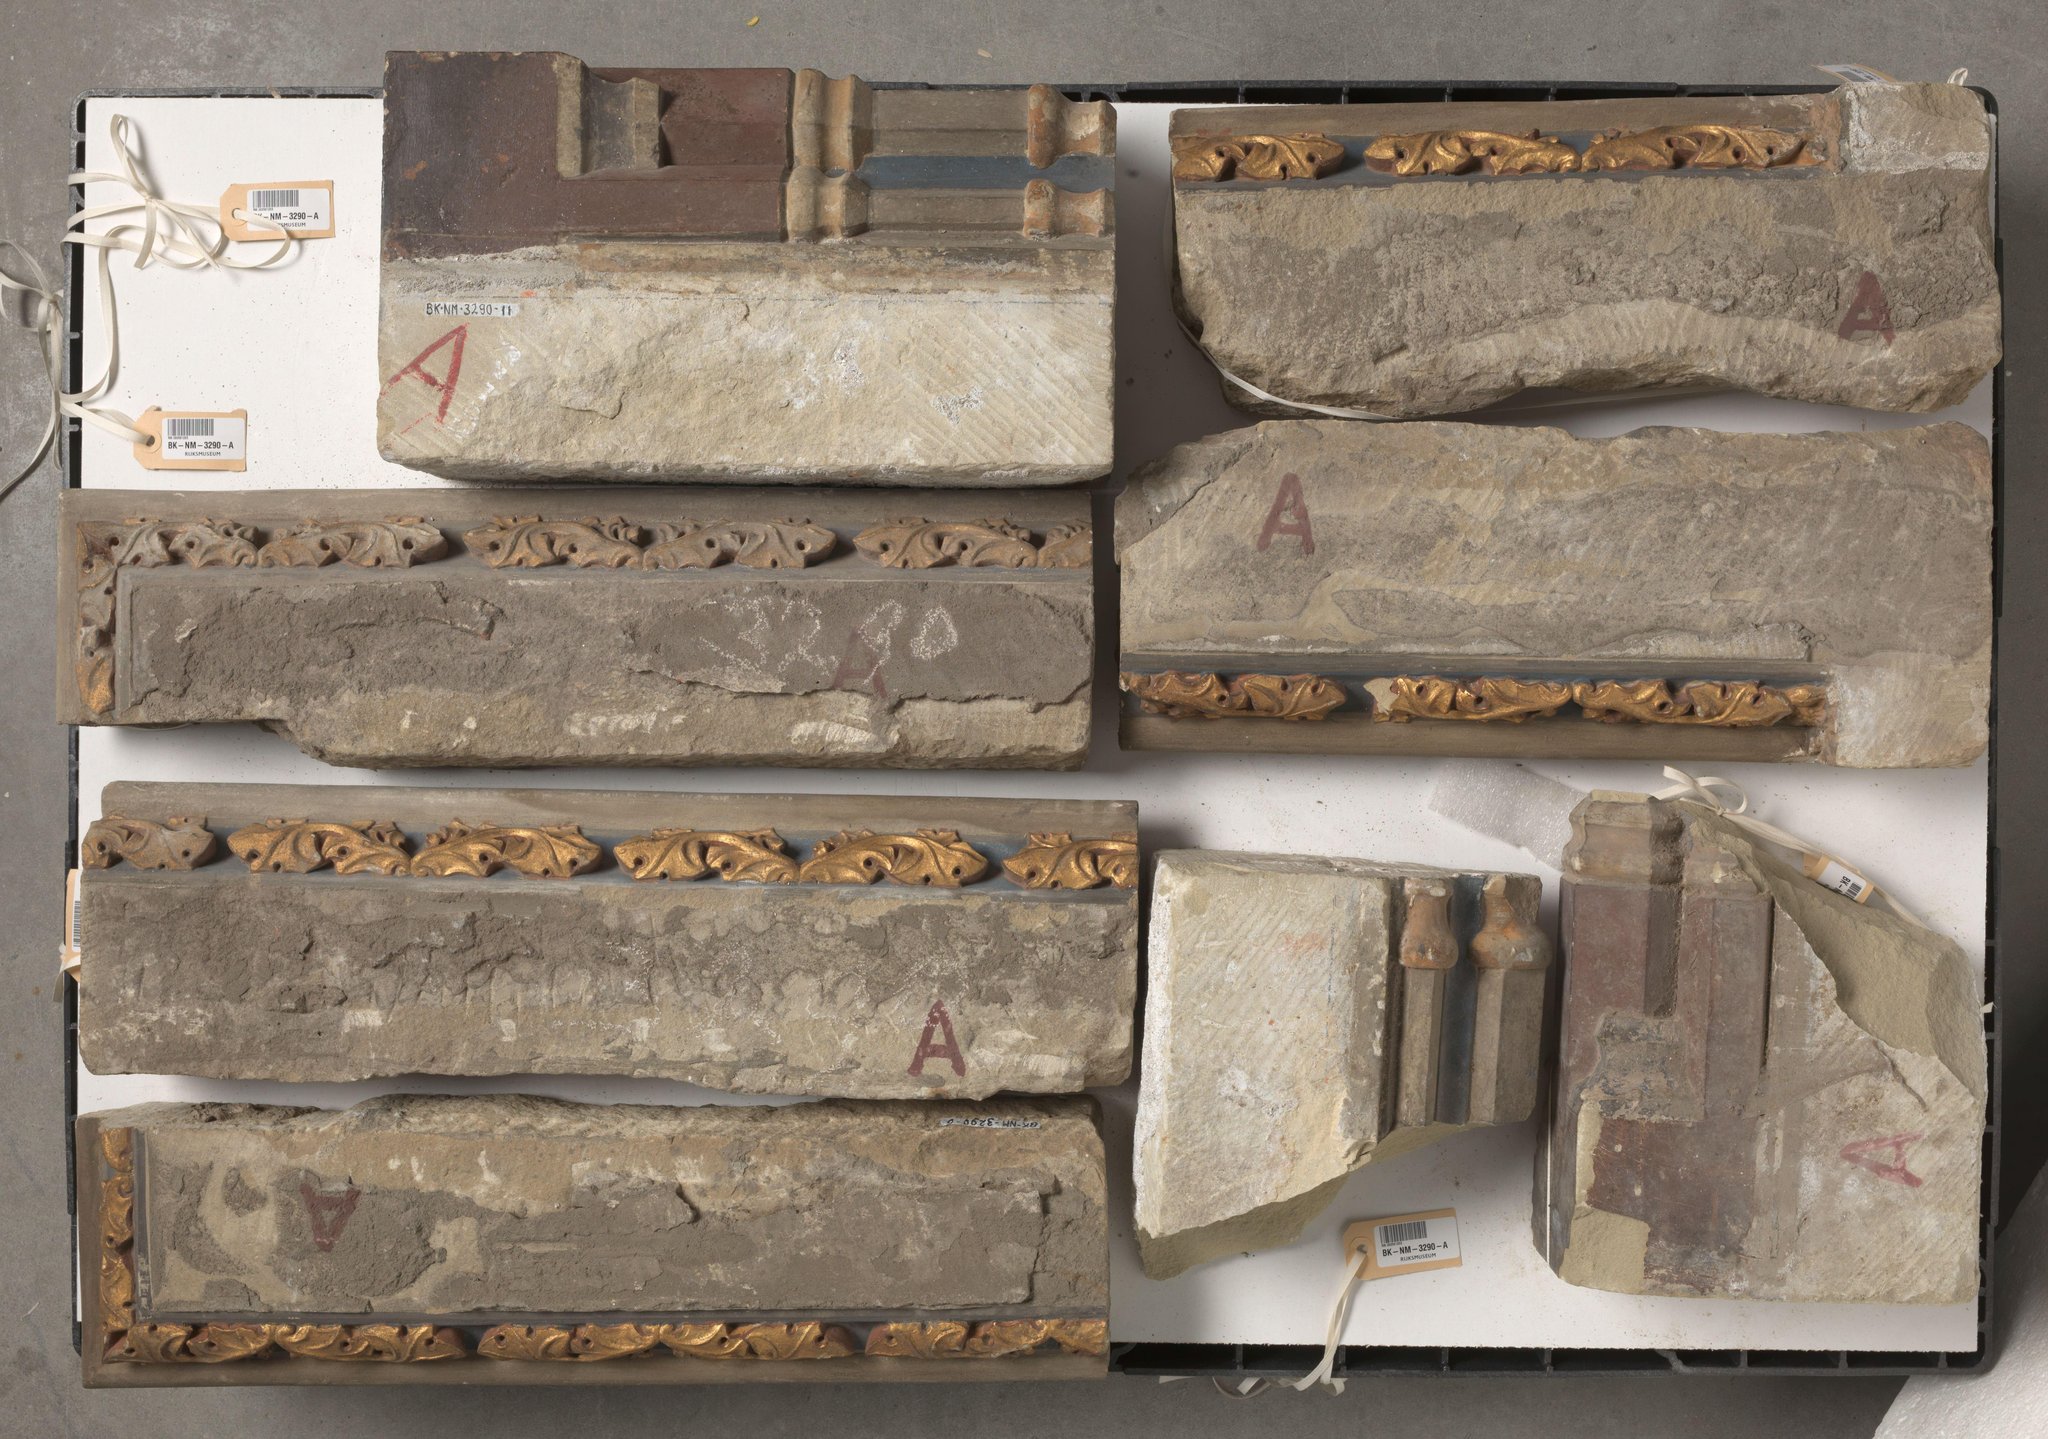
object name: schoorsteenfries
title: Onderdelen van een schoorsteenfries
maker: Anonymous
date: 1510-1525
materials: stone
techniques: hewing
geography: utrecht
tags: madonna on the crescent of the moon (sometimes called queen of heaven) (in mandorla)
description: De onderdelen hebben de nummers BK-NM-3290-6, -7, -8, -9, -10, en -11.